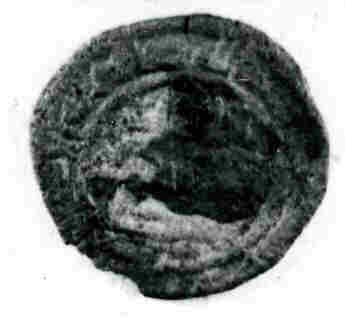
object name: coin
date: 184-800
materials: copper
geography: jay